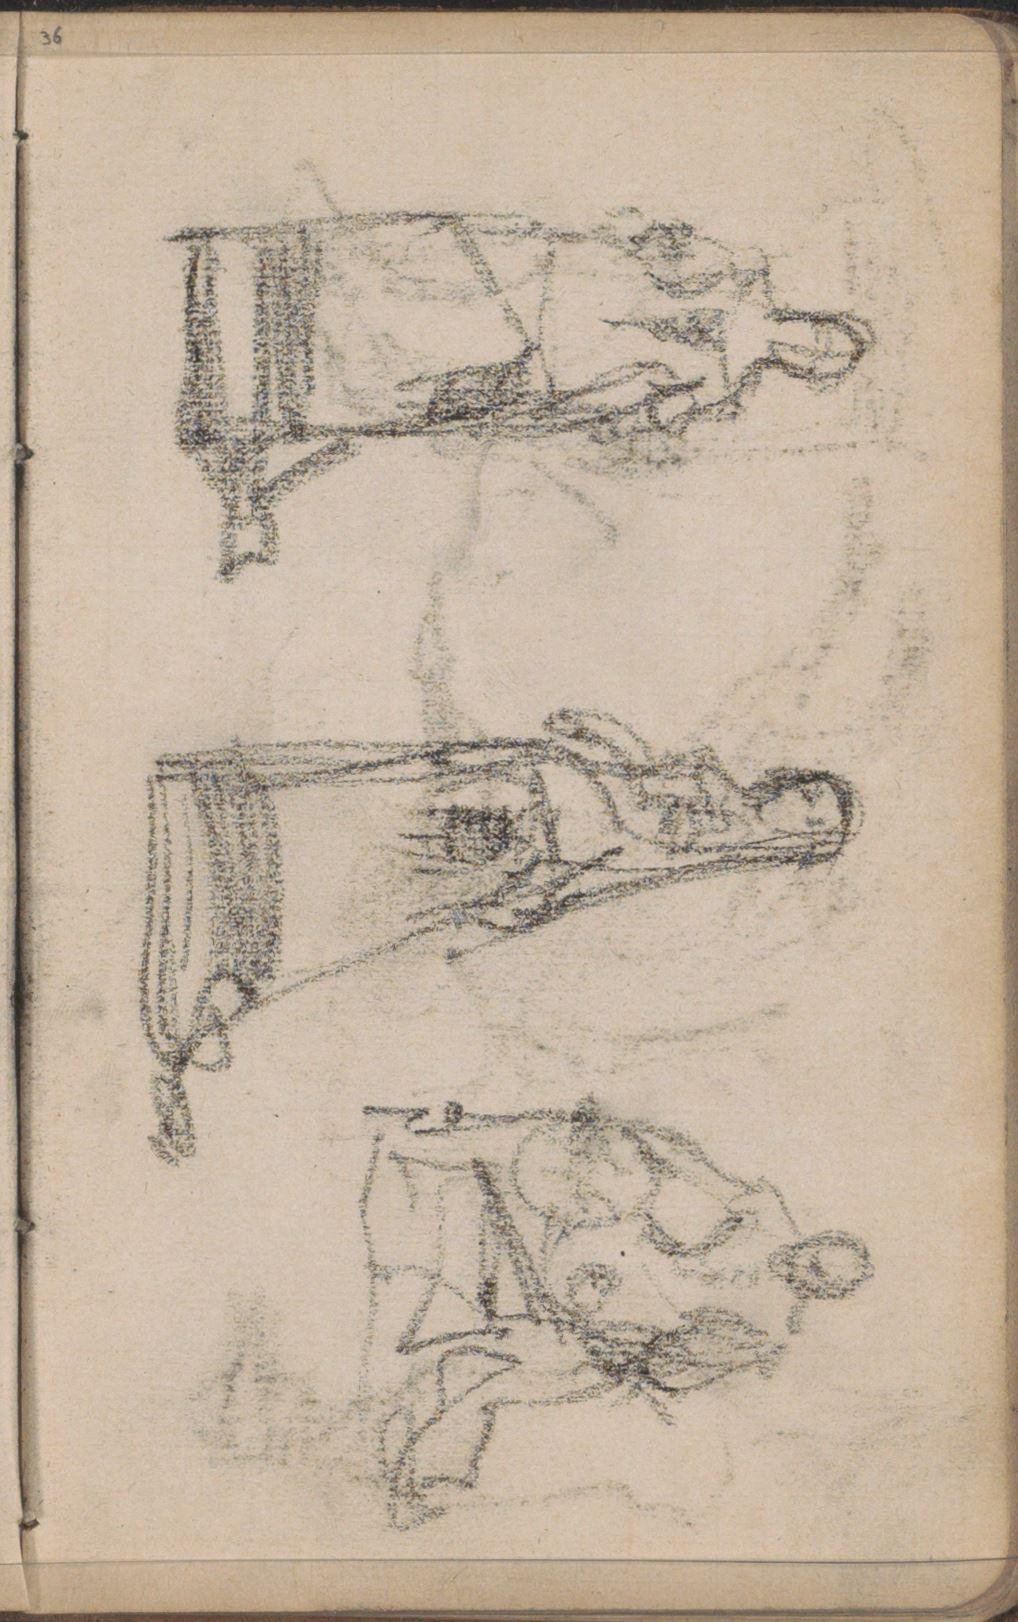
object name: sketchbook leaf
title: Vrouwfiguren en man met een zwaard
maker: marius bauer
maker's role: draughtsman, print maker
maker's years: 1867-1932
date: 1879-1885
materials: chalk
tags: standing figure, adult woman, adult man, hacking and thrusting weapons: sword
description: Pagina 36 uit een schetsboek met 58 bladen.